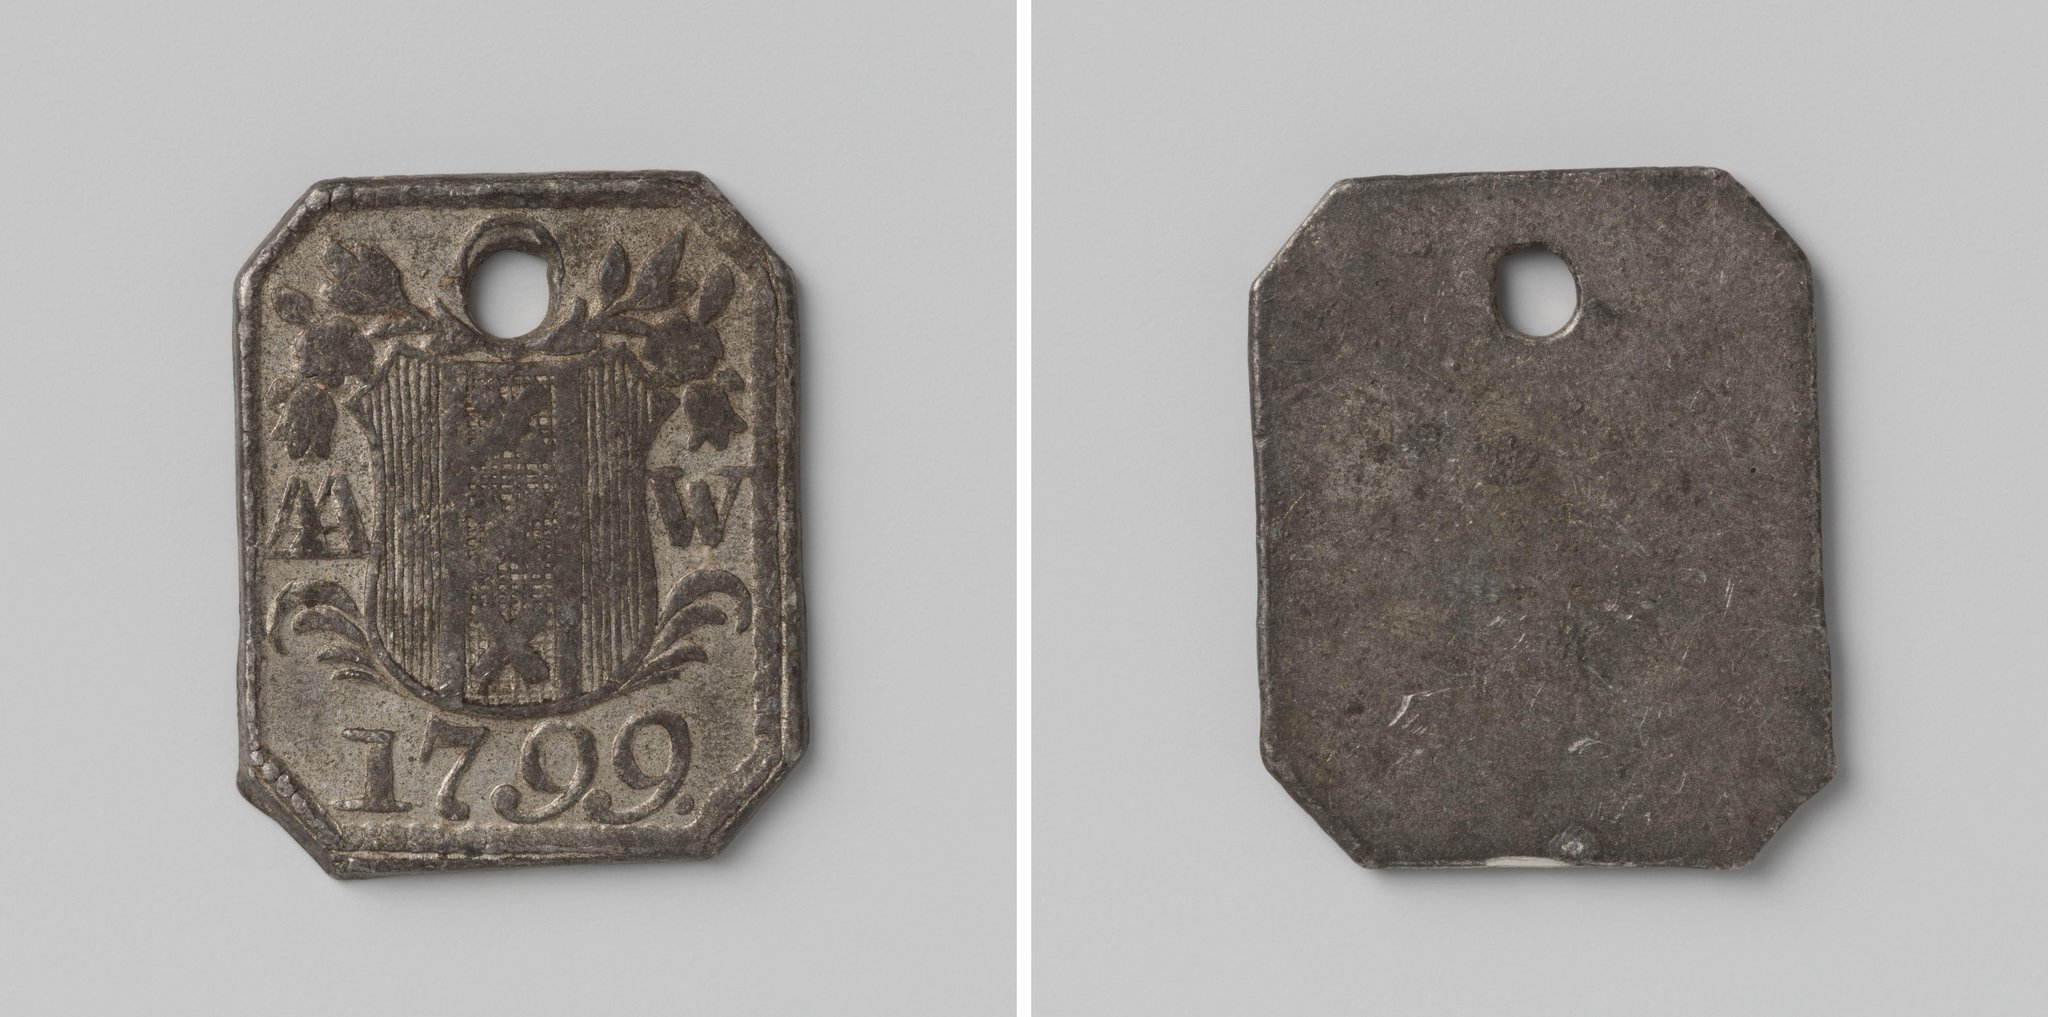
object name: tax token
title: Aalmoezeniersweeshuis te Amsterdam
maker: Anonymous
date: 1799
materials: tin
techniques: striking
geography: amsterdam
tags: amsterdam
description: eenzijdig, rechthoekig loodje met afgeschuinde hoeken en gat erin. Voorzijde: wapenschild, omgeven door bladertakjes tussen opschrift AAW boven jaartal. Keerzijde: blanco